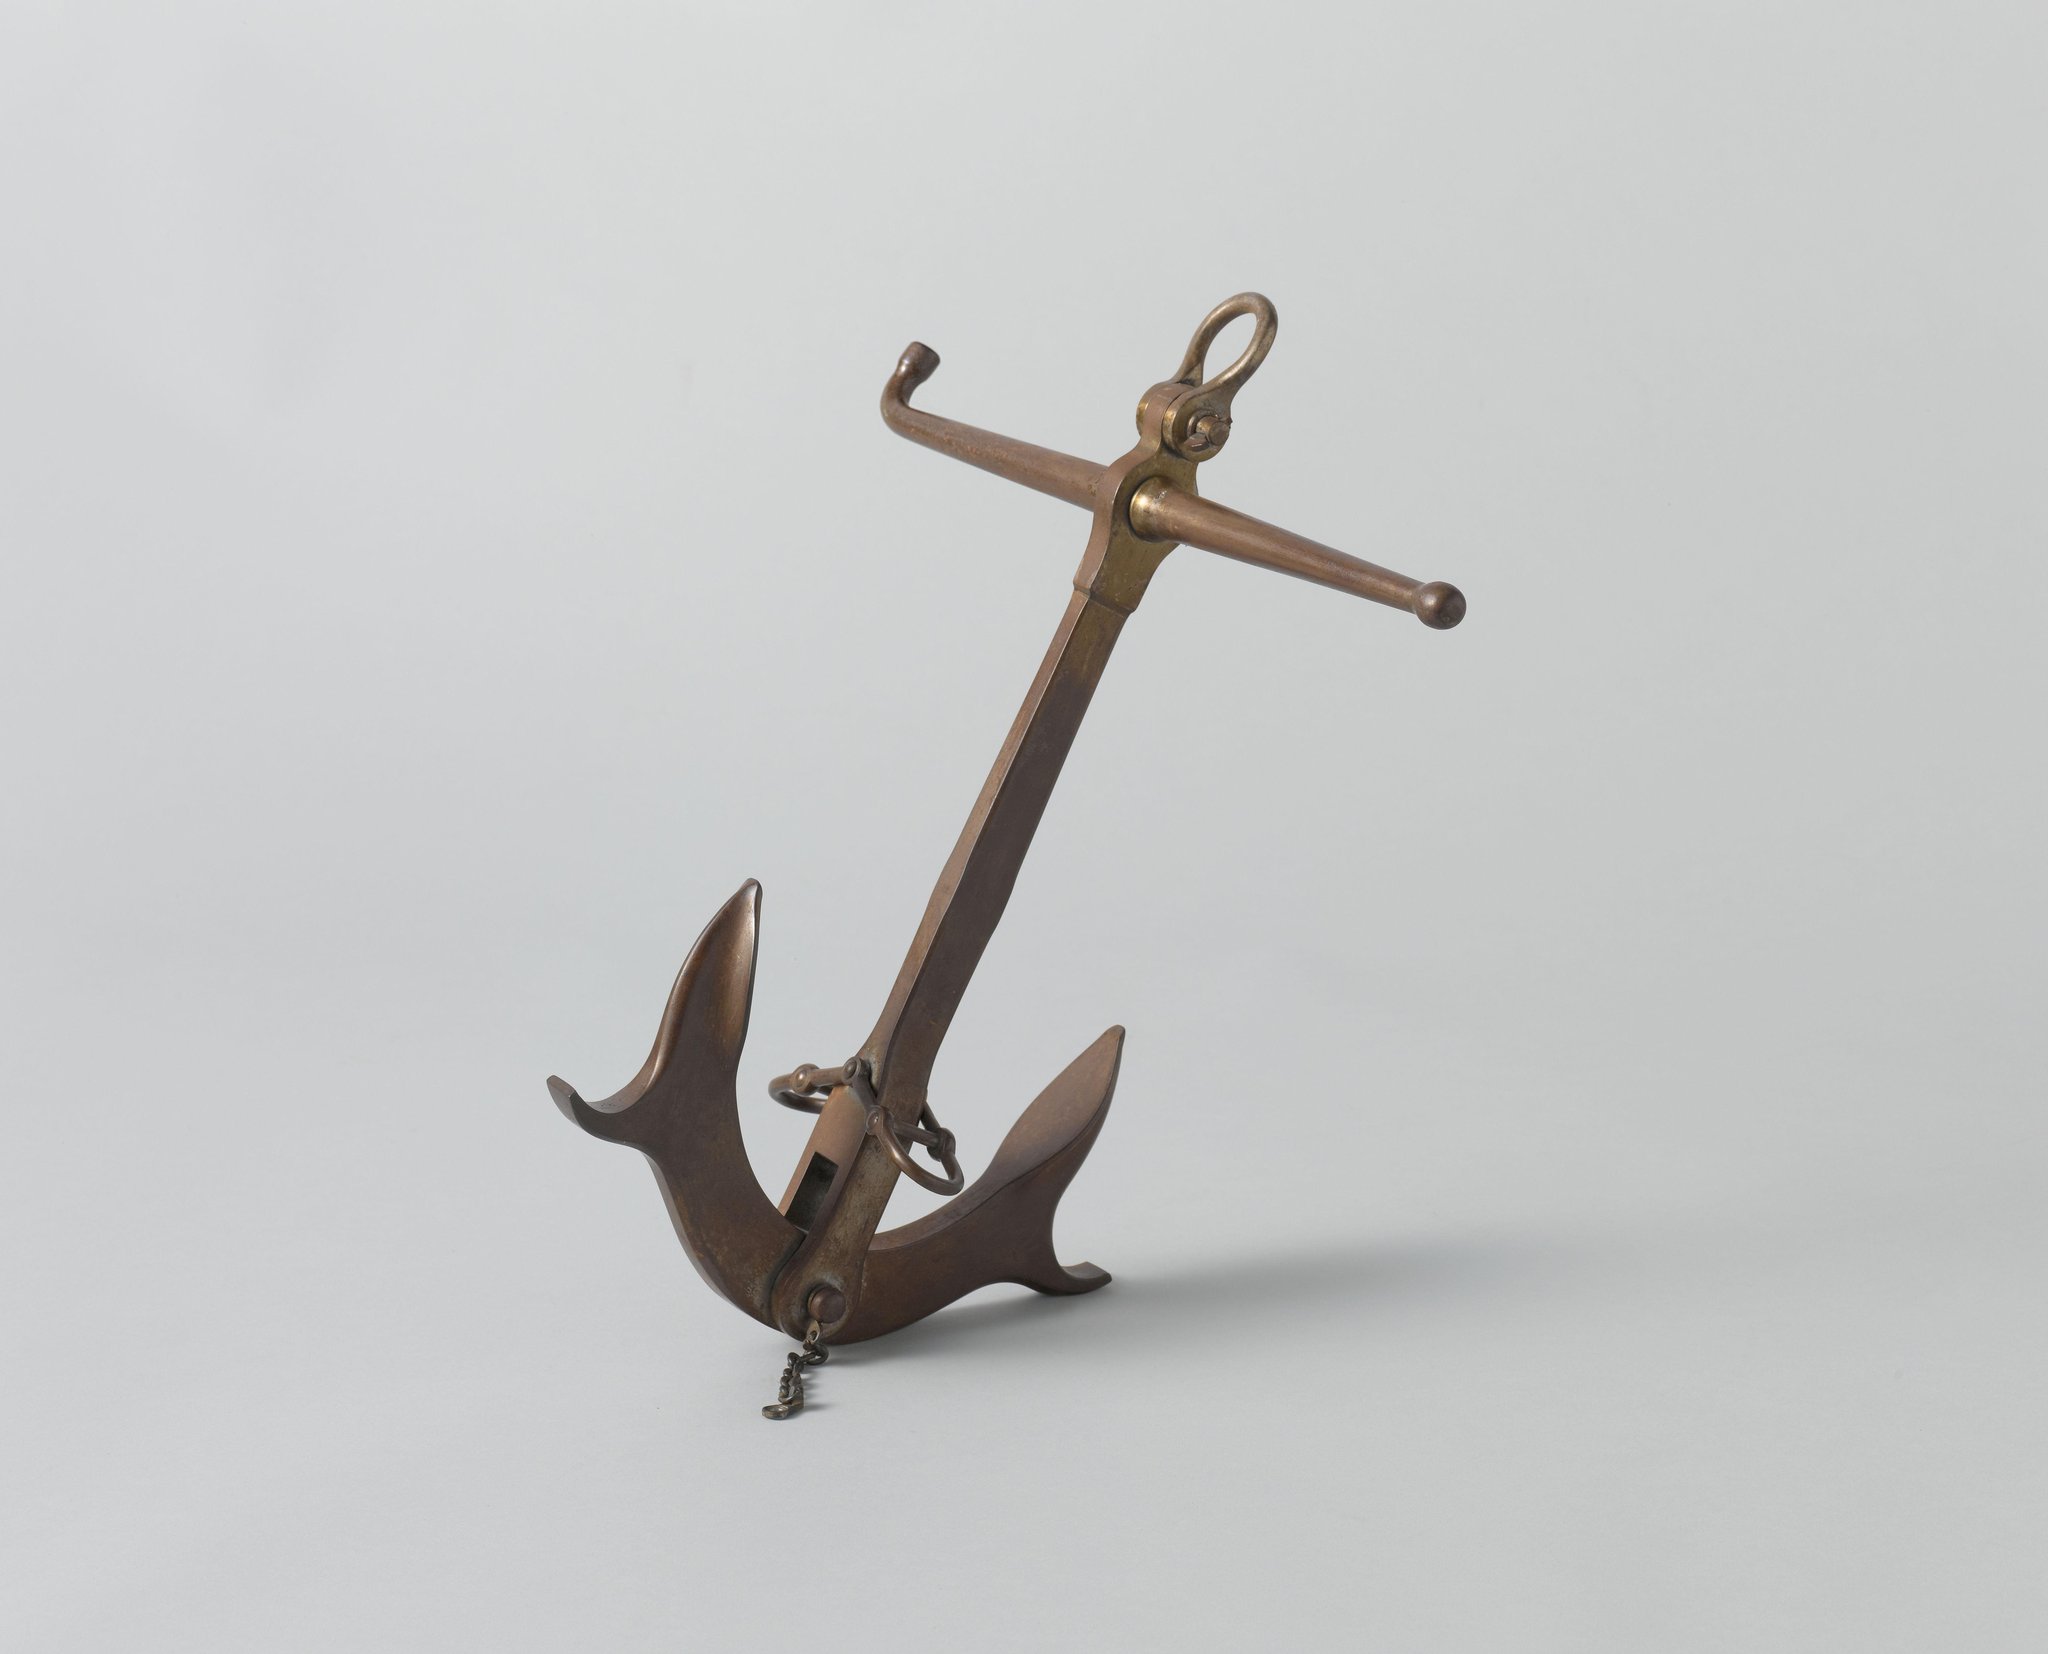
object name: demonstration model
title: Model of an Anchor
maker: Anonymous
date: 1845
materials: iron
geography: netherlands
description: Model van een Porter's stokanker. De armen draaien om een as in het gevorkte eind van de schacht; de hoek van de armen is kleiner dan gewoonlijk en de handen zijn voorzien van een hoorn aan de buitenkant. De ankerstok kan door het gat van de schacht geschoven worden en parallel aan de schacht. Aan het uiteinden van de schacht zit een harp, bij het kruis een ketting en om de schacht heen een dubbele schalm.